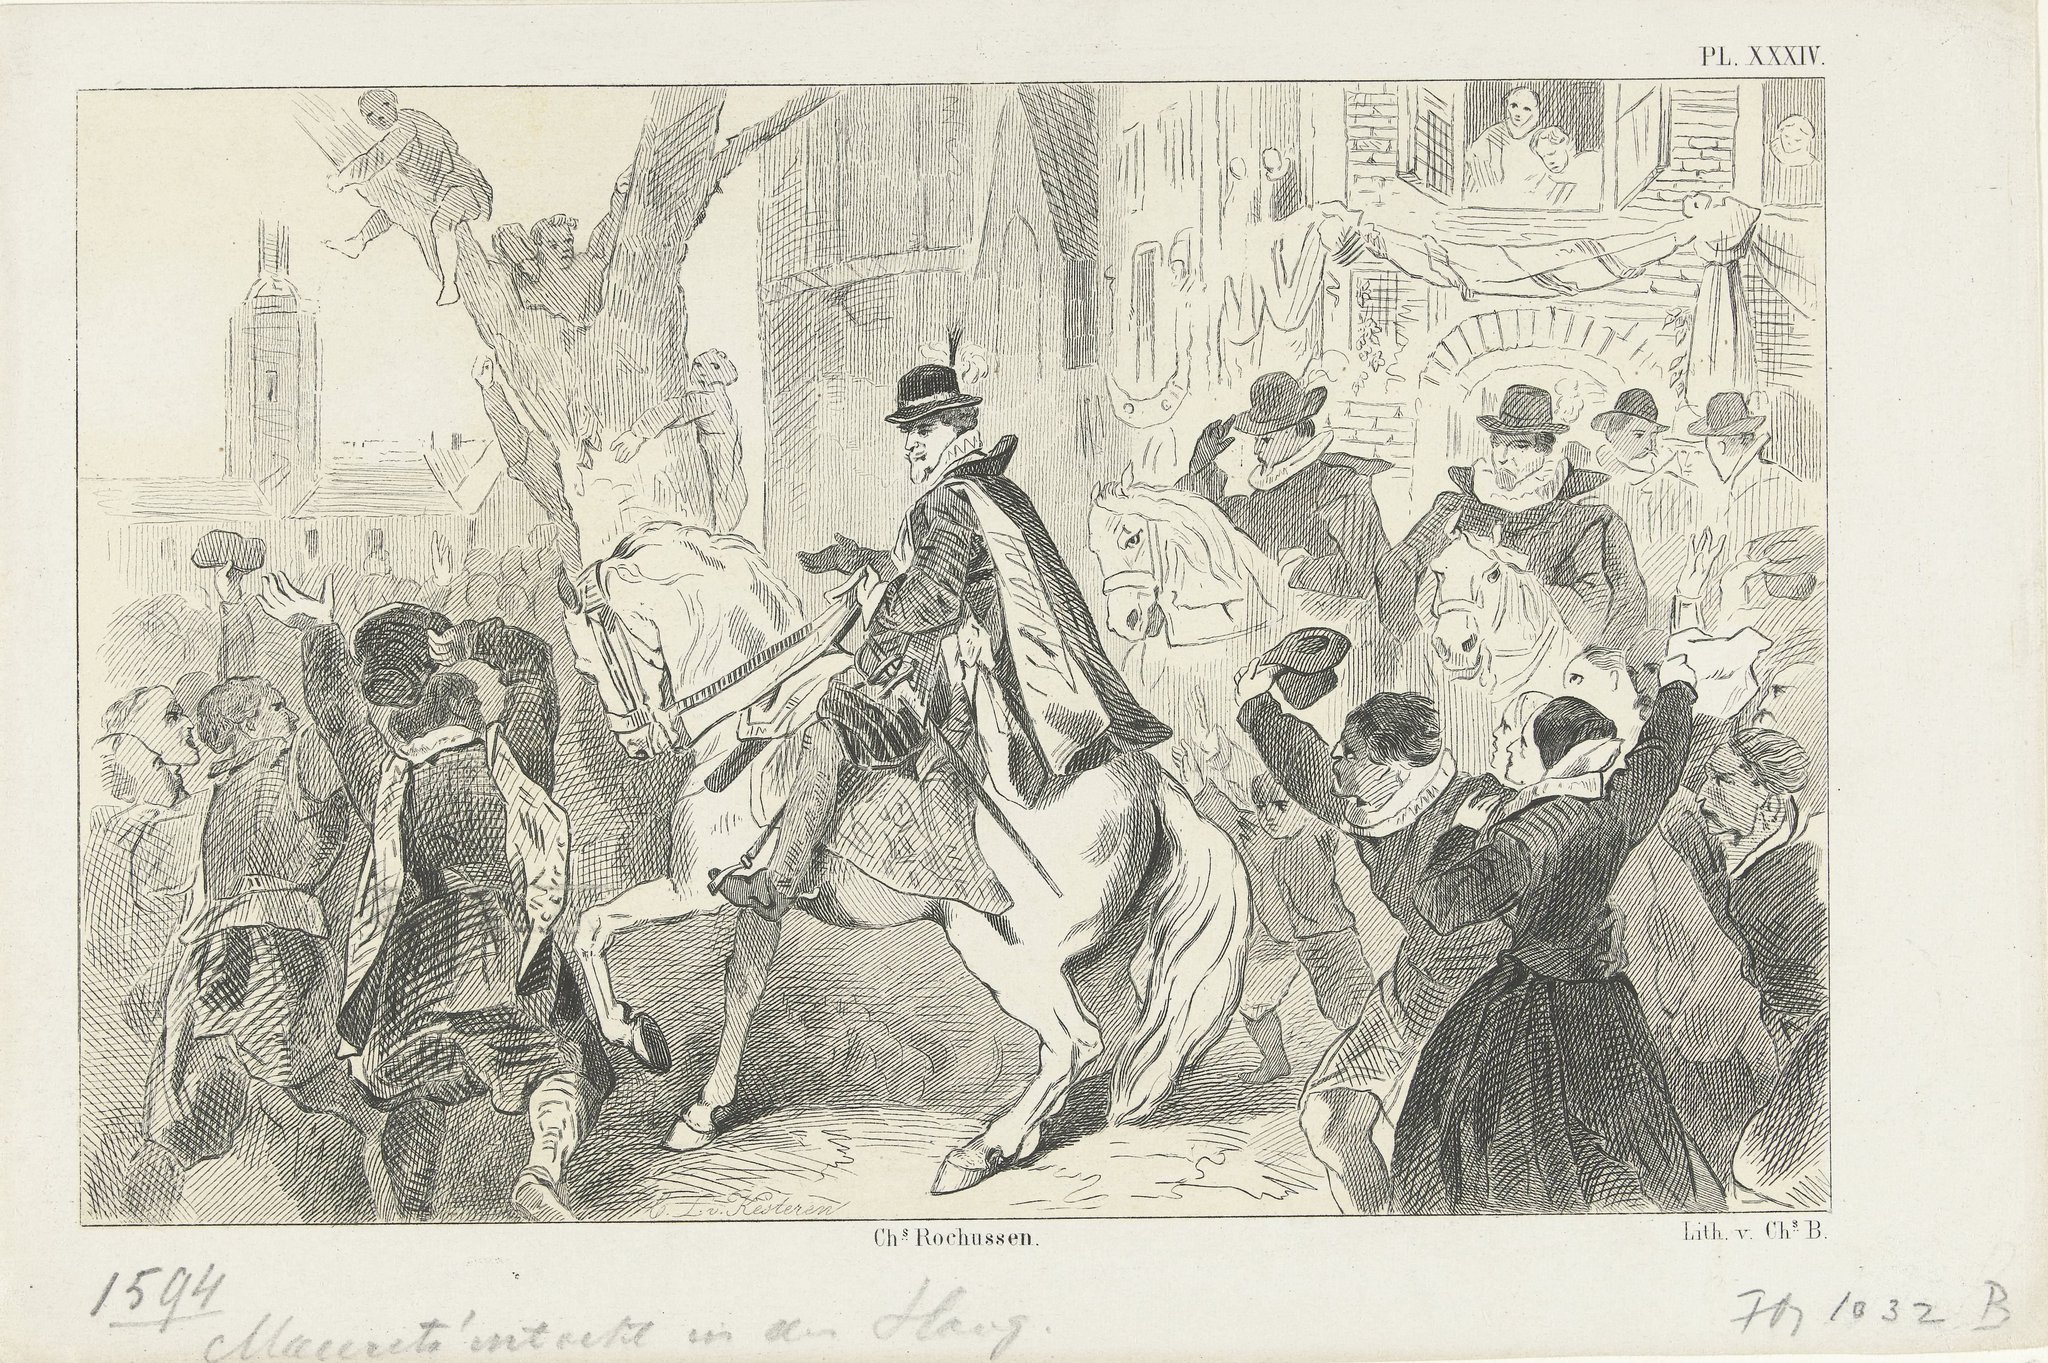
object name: history print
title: Intocht van Maurits in Den Haag, 1594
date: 1853-1861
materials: paper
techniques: tone lithography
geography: netherlands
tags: maurice (prince of orange), triumphal entry and public reception, pageant, 'entrée solennelle', 'joyeuse entrée', the hague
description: Gebruikt als illustratie in: Jacob van Lennep, De geschiedenis des vaderlands in schetsen en afbeeldingen, Binger, Amsterdam 1855-1861, 8 delen, pl. XXXIV.